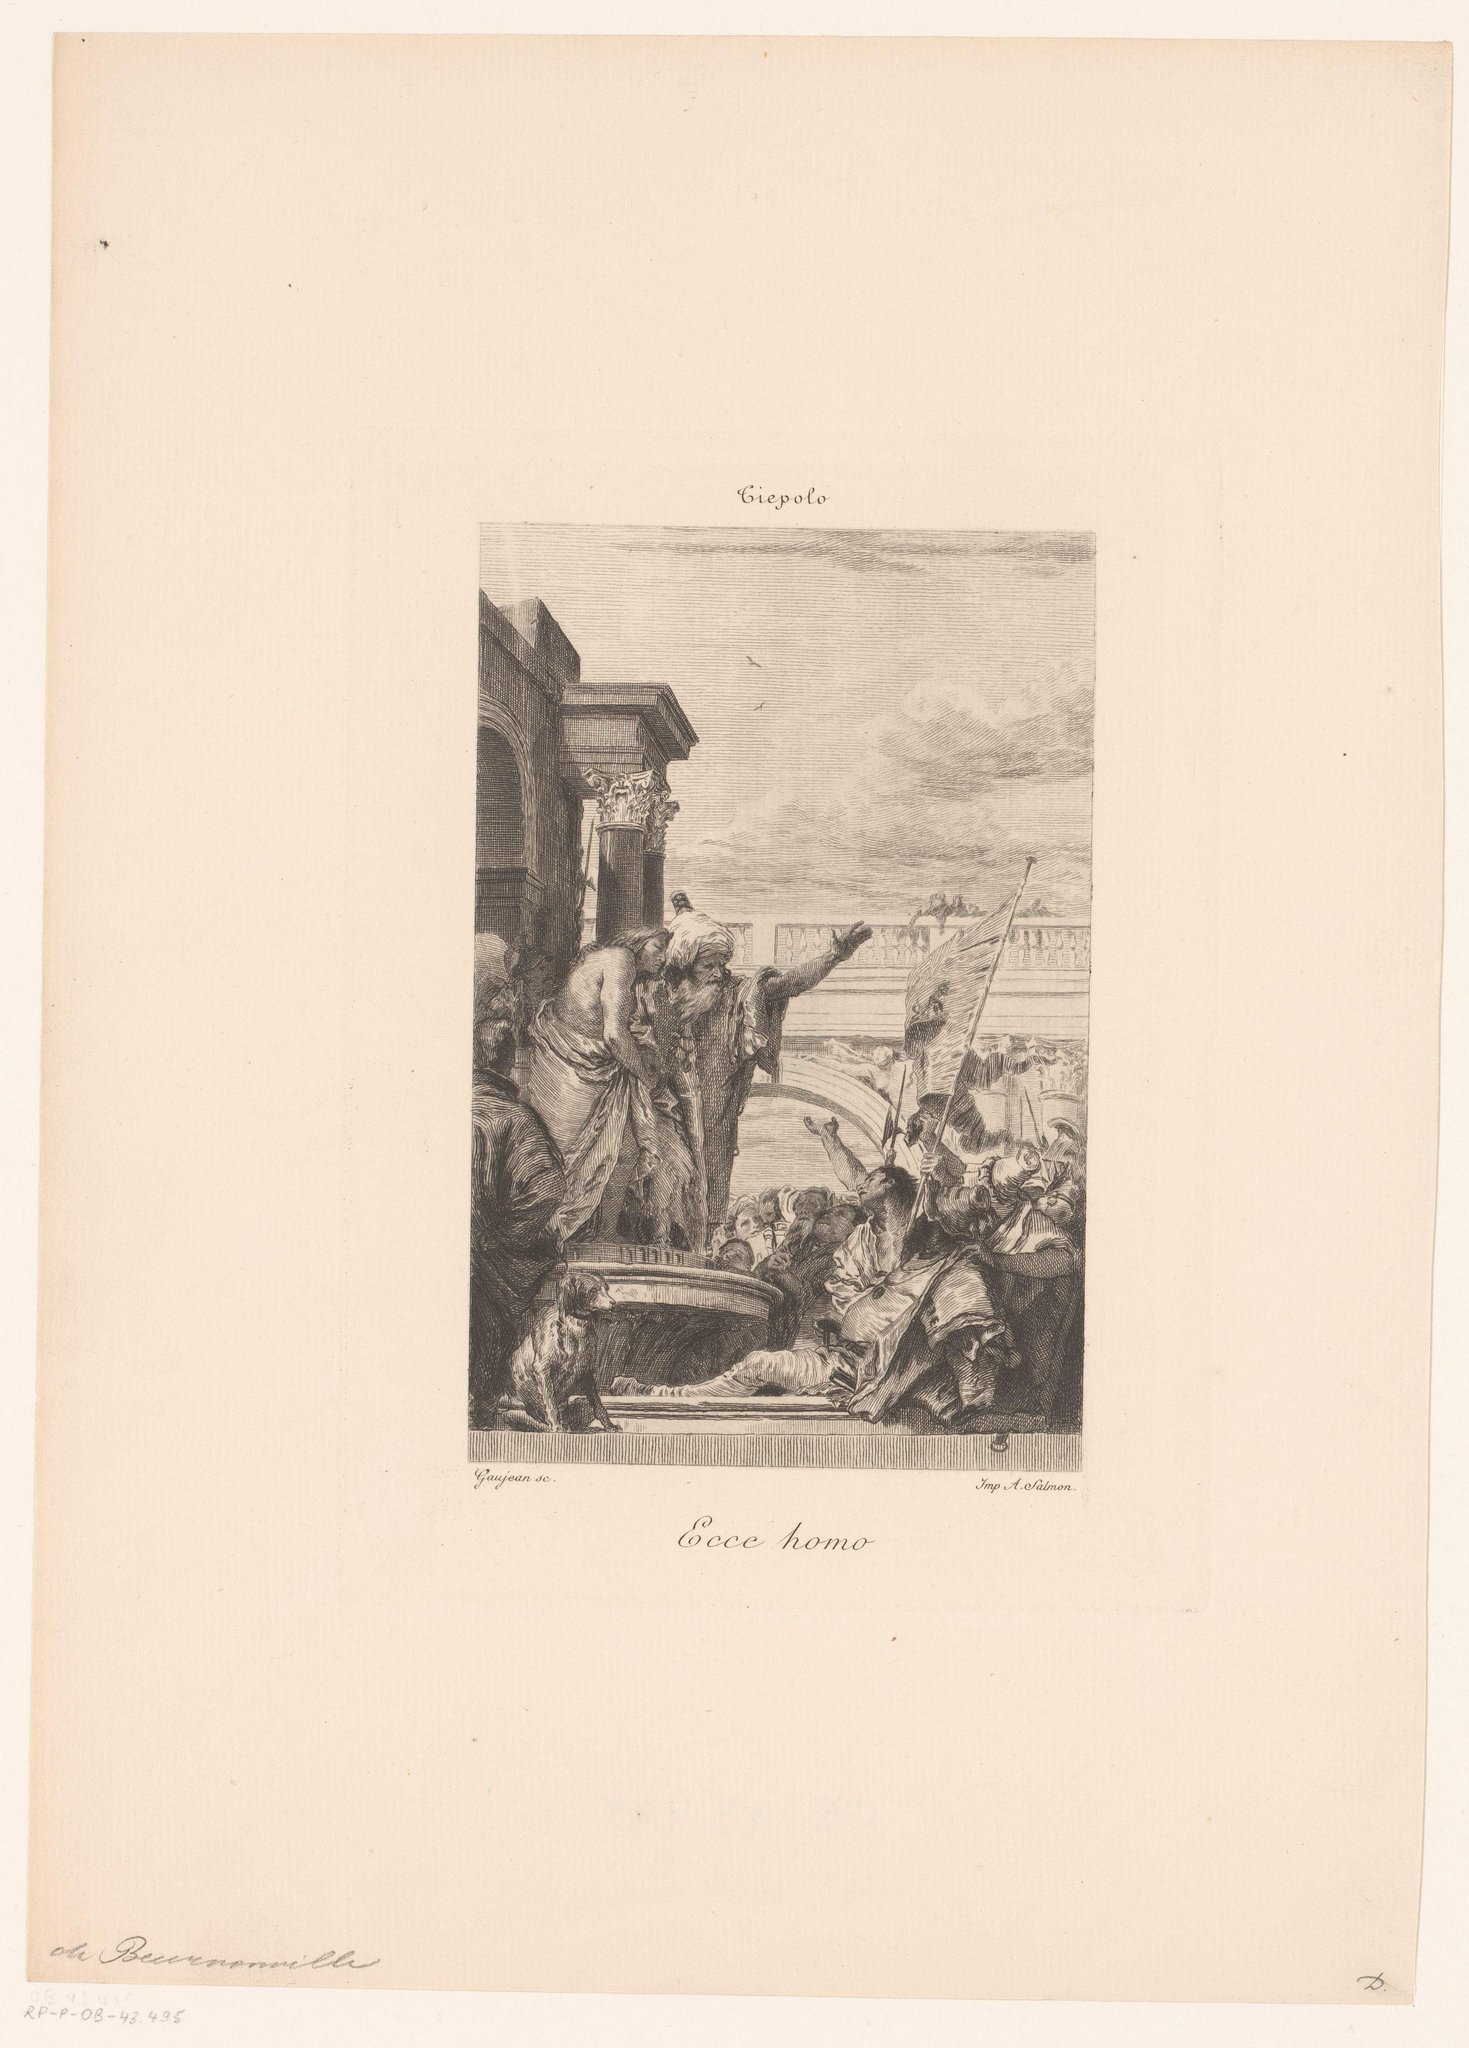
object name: print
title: Serie prenten naar schilderijen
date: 1860-1900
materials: paper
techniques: engraving, etching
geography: paris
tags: christ alone (also called 'ecce homo')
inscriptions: collector's mark: Lugt 2228